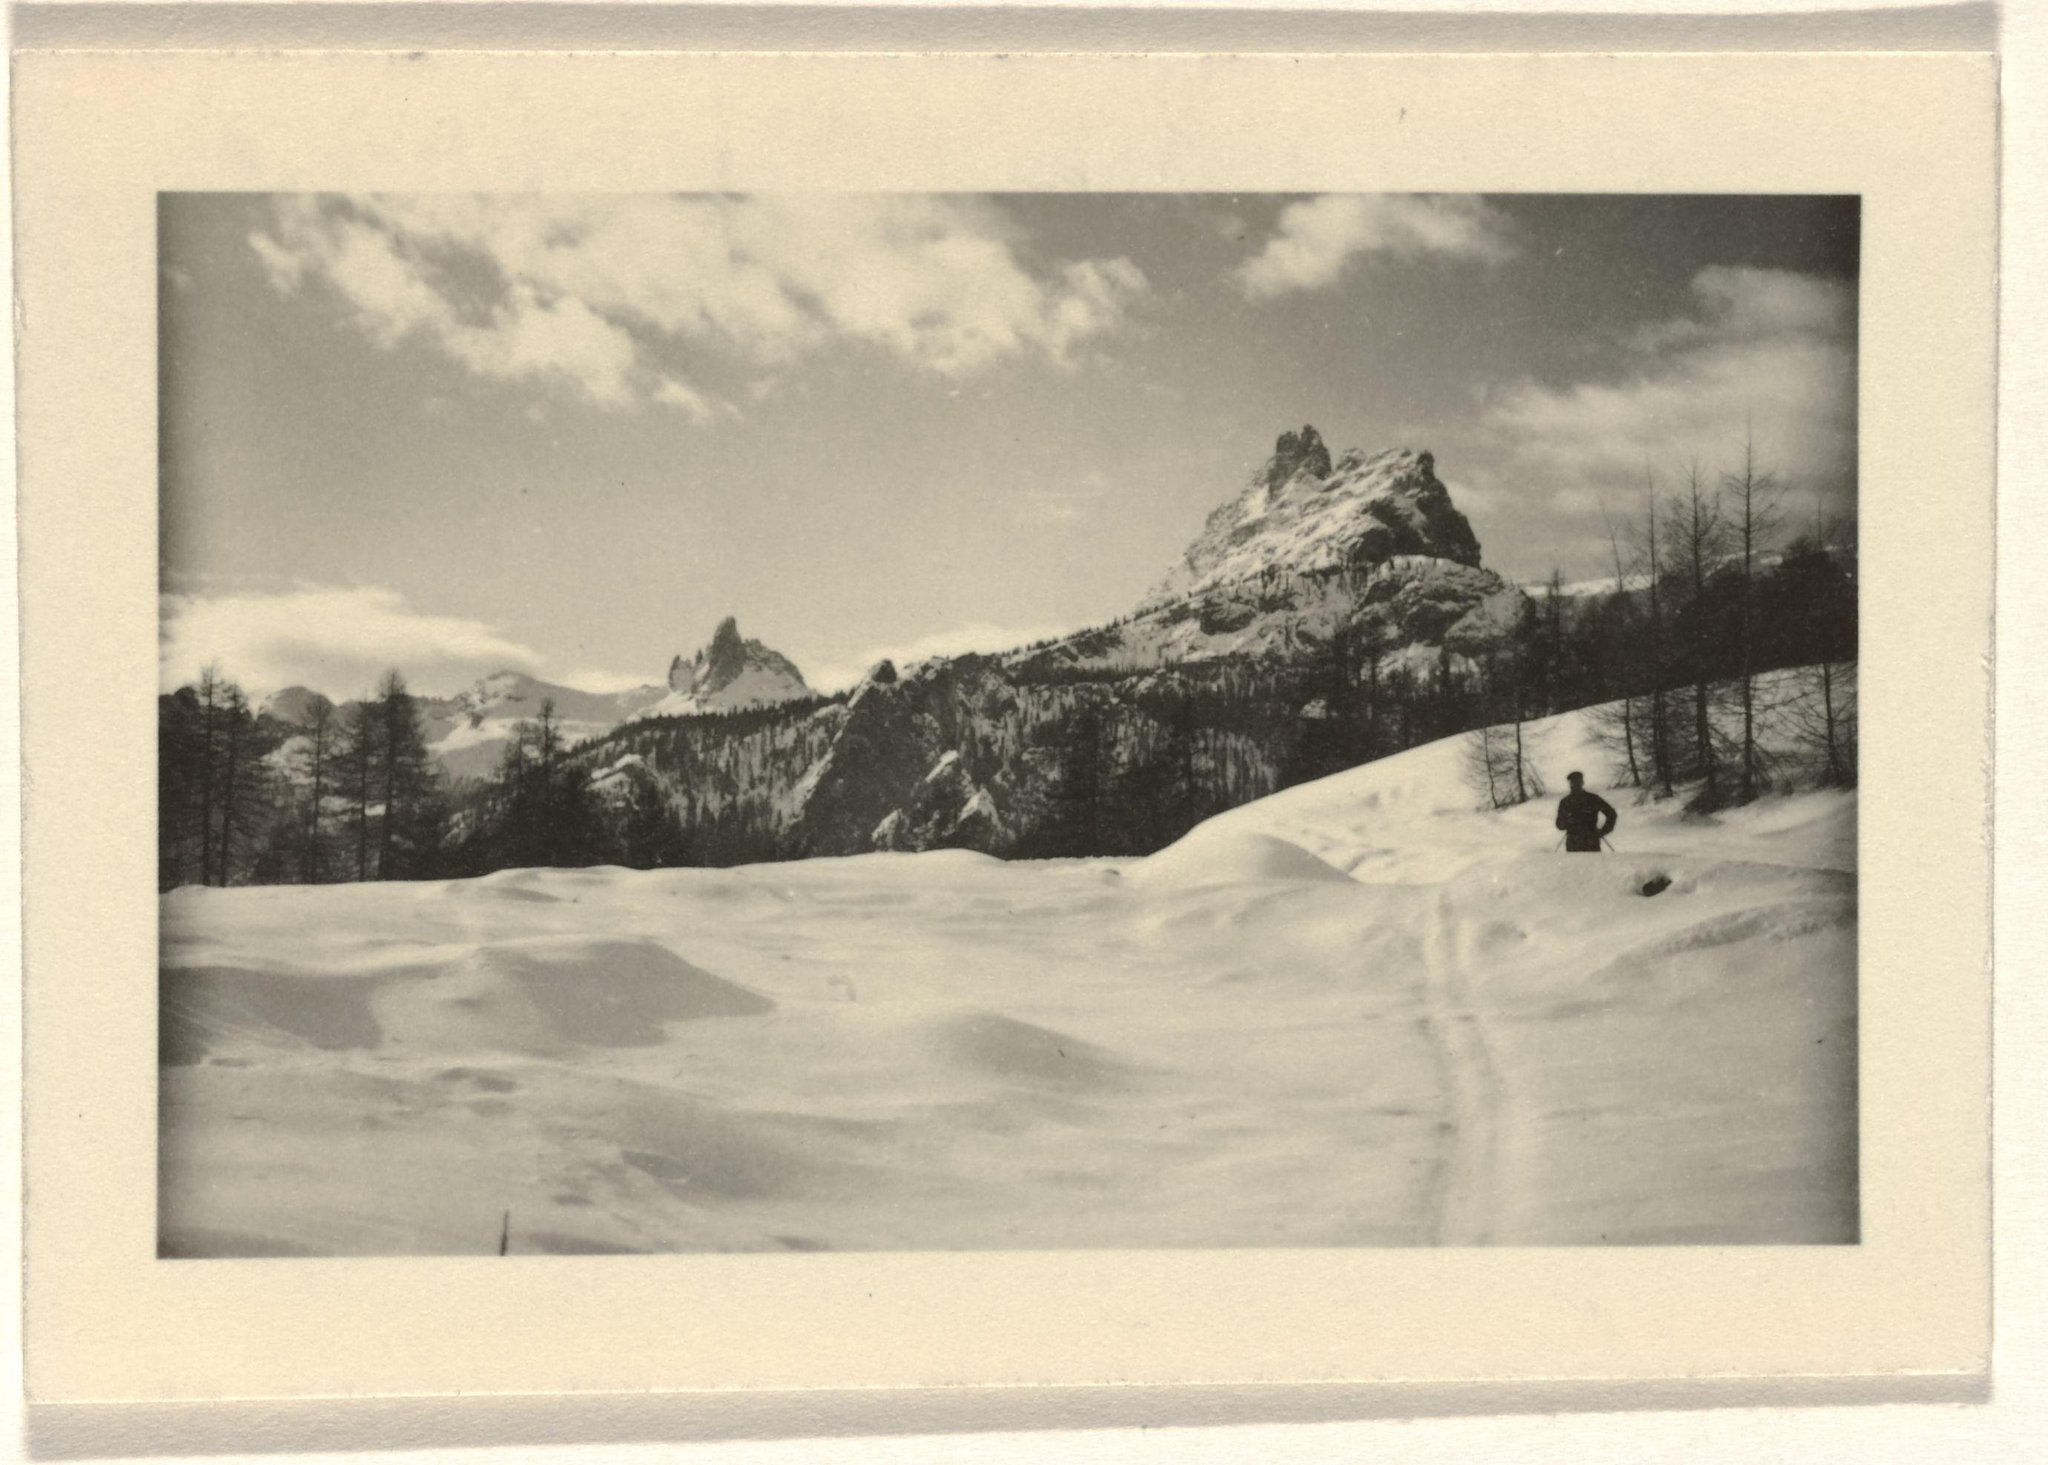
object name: photograph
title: Besneeuwd berglandschap, met bomen en sneeuwvlakte op de voorgrond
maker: Anonymous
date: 1930-1975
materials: photographic support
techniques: gelatin silver print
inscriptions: number: ‘Weg zum Fabrarigo-Pass’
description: Besneeuwd berglandschap, met bomen en sneeuwvlakte op de voorgrond.